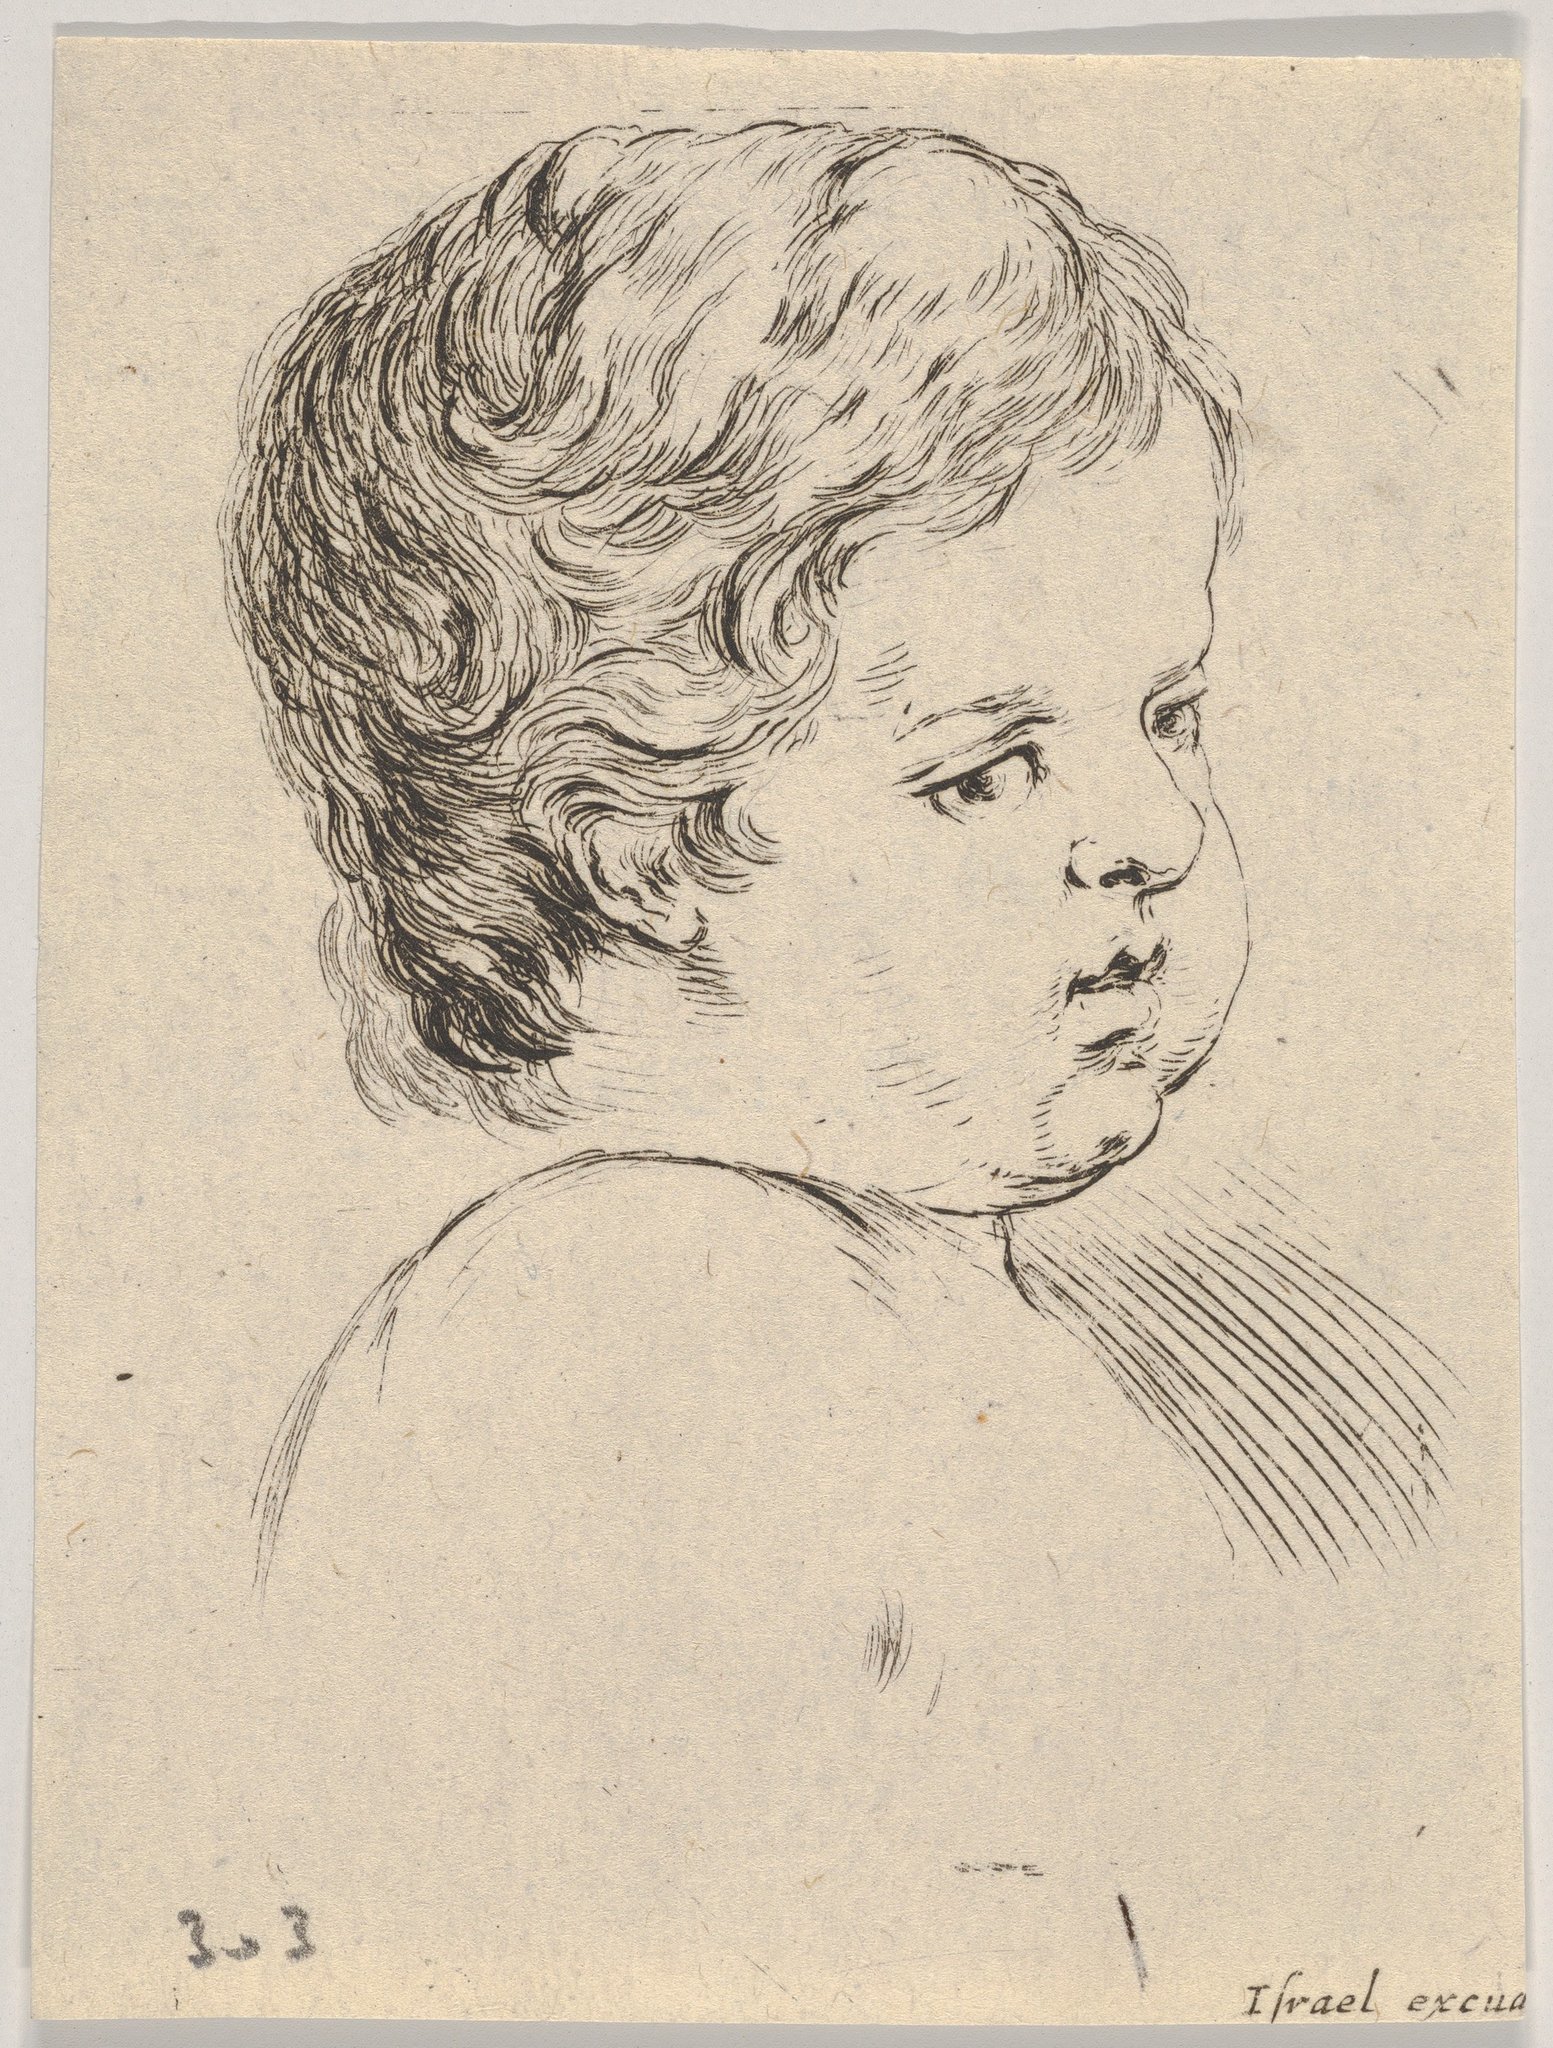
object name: print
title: Plate 12: Head of a child, from "The Book for Learning to Draw" (Livre pour apprendre à dessiner)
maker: stefano della bella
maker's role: artist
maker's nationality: italian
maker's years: 1610-1664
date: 1649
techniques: etching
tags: heads,children,portraits